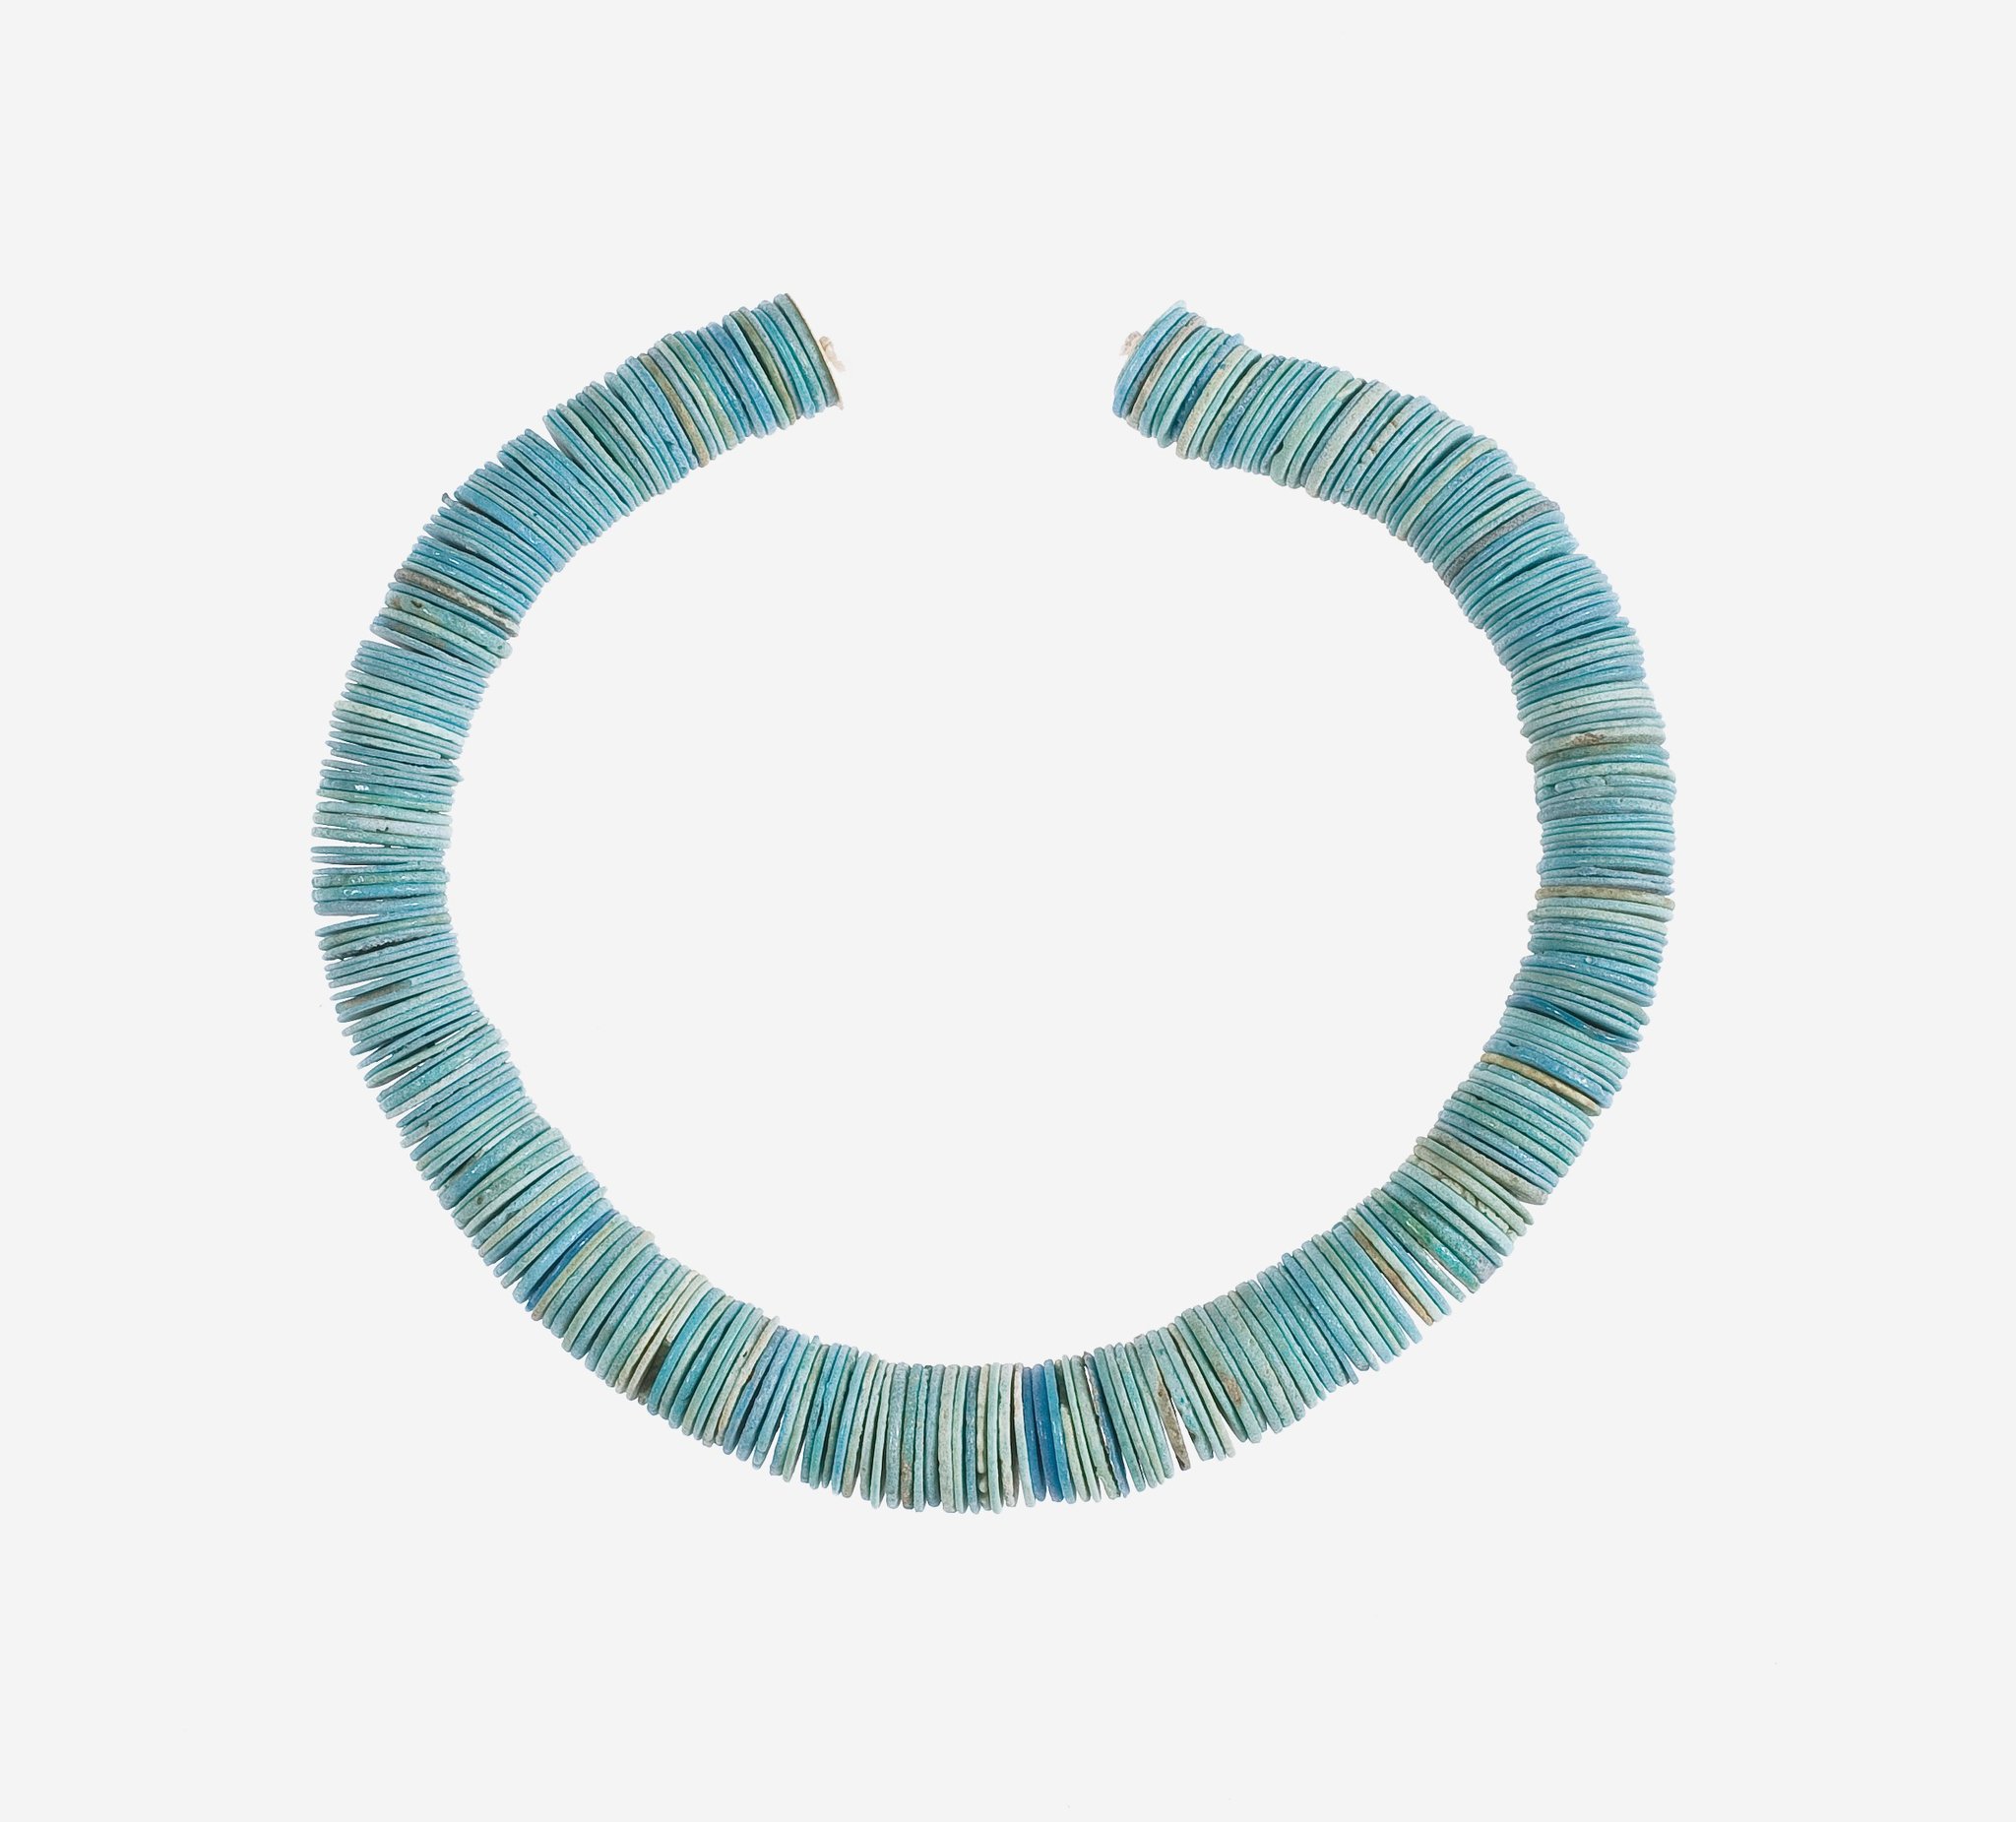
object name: bead, disk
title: String of Large Flat Disk Beads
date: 1390-1352 BCE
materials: faience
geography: egypt